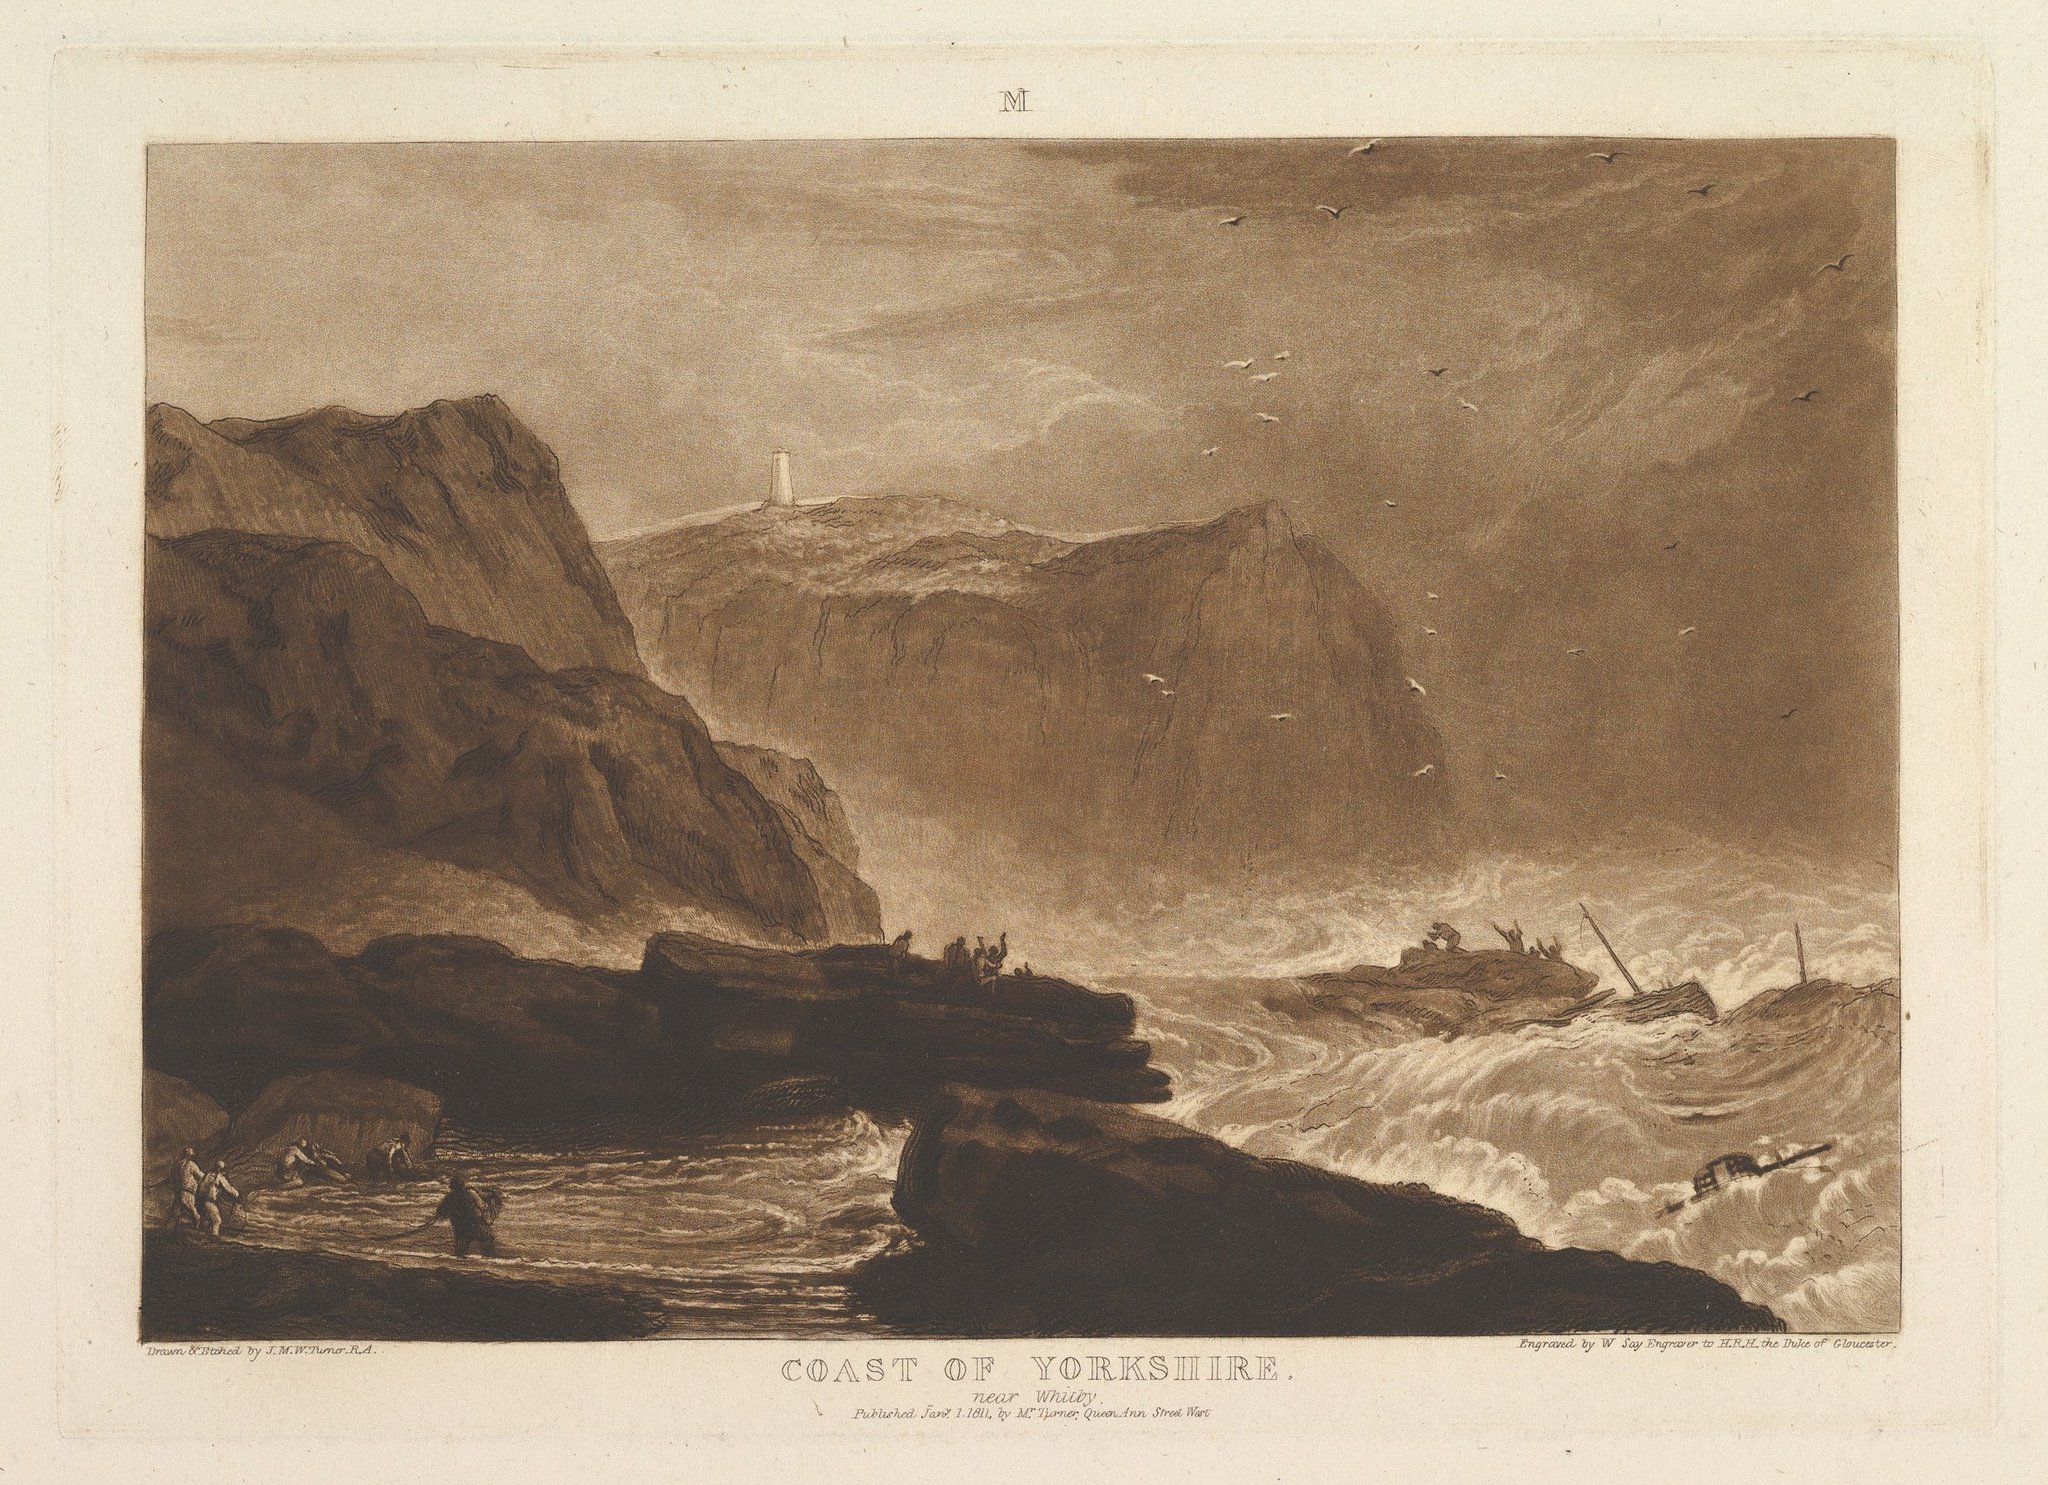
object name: print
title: Coast of Yorkshire, Near Whitby, part V, plate 24 from "Liber Studiorum"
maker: joseph mallord william turner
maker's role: artist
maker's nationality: british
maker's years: 1775-1851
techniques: etching, mezzotint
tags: mountains